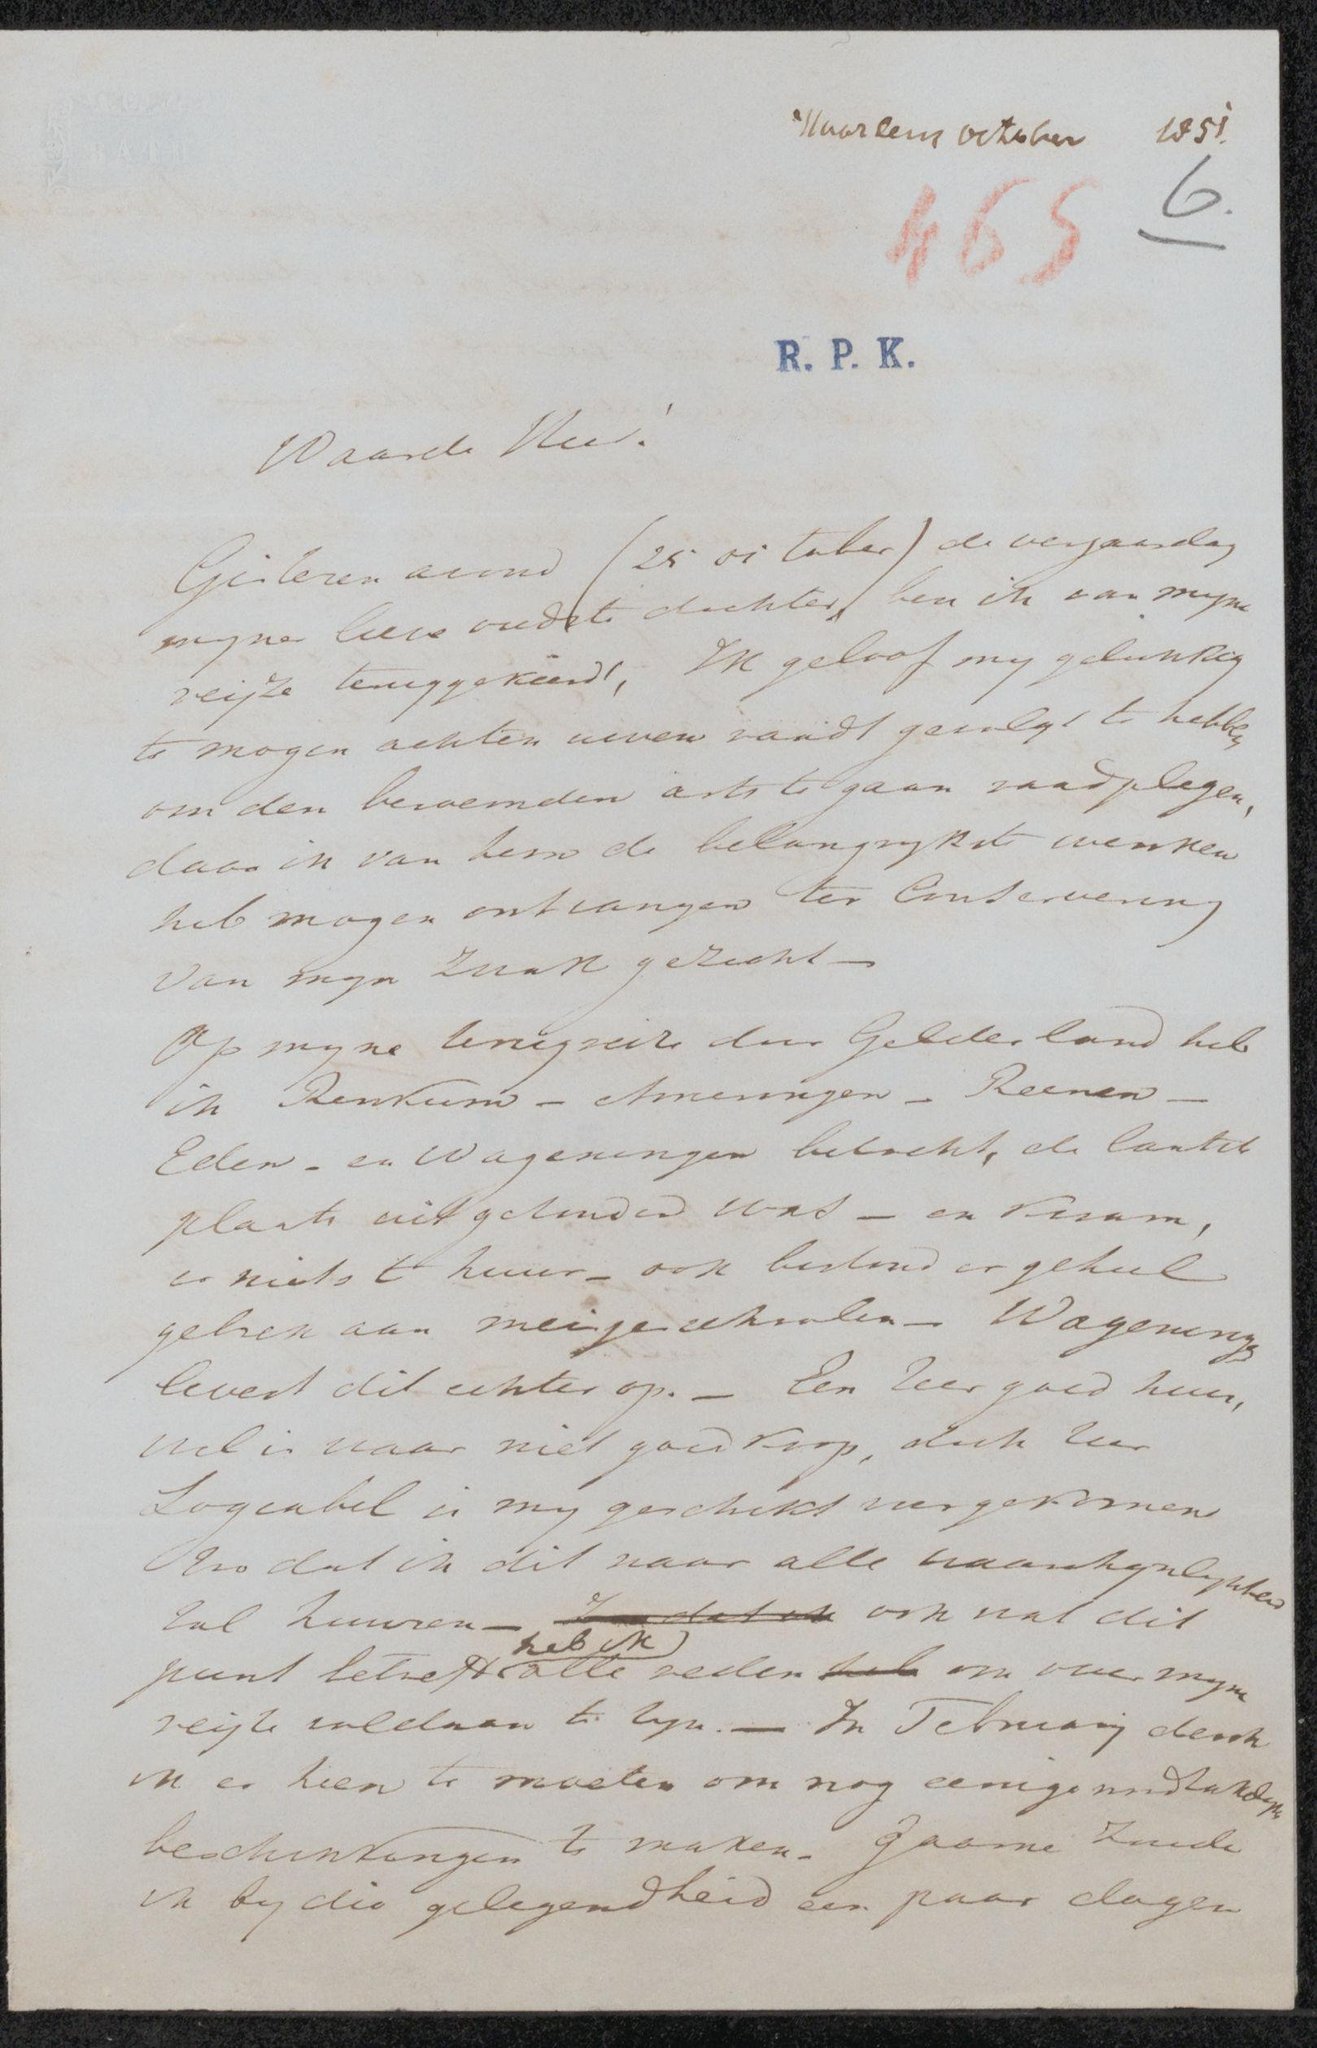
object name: letter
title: Brief aan Christiaan Kramm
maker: christiaan immerzeel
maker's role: print maker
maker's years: 1808-1886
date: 1851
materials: ink, paper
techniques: pen, writing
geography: haarlem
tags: utrecht, print maker, draughtsman, christiaan kramm, painter, servaes de jong, the graphic arts, family life, rhenen, amerongen, gelderland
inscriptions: collector's mark: Lugt 2233